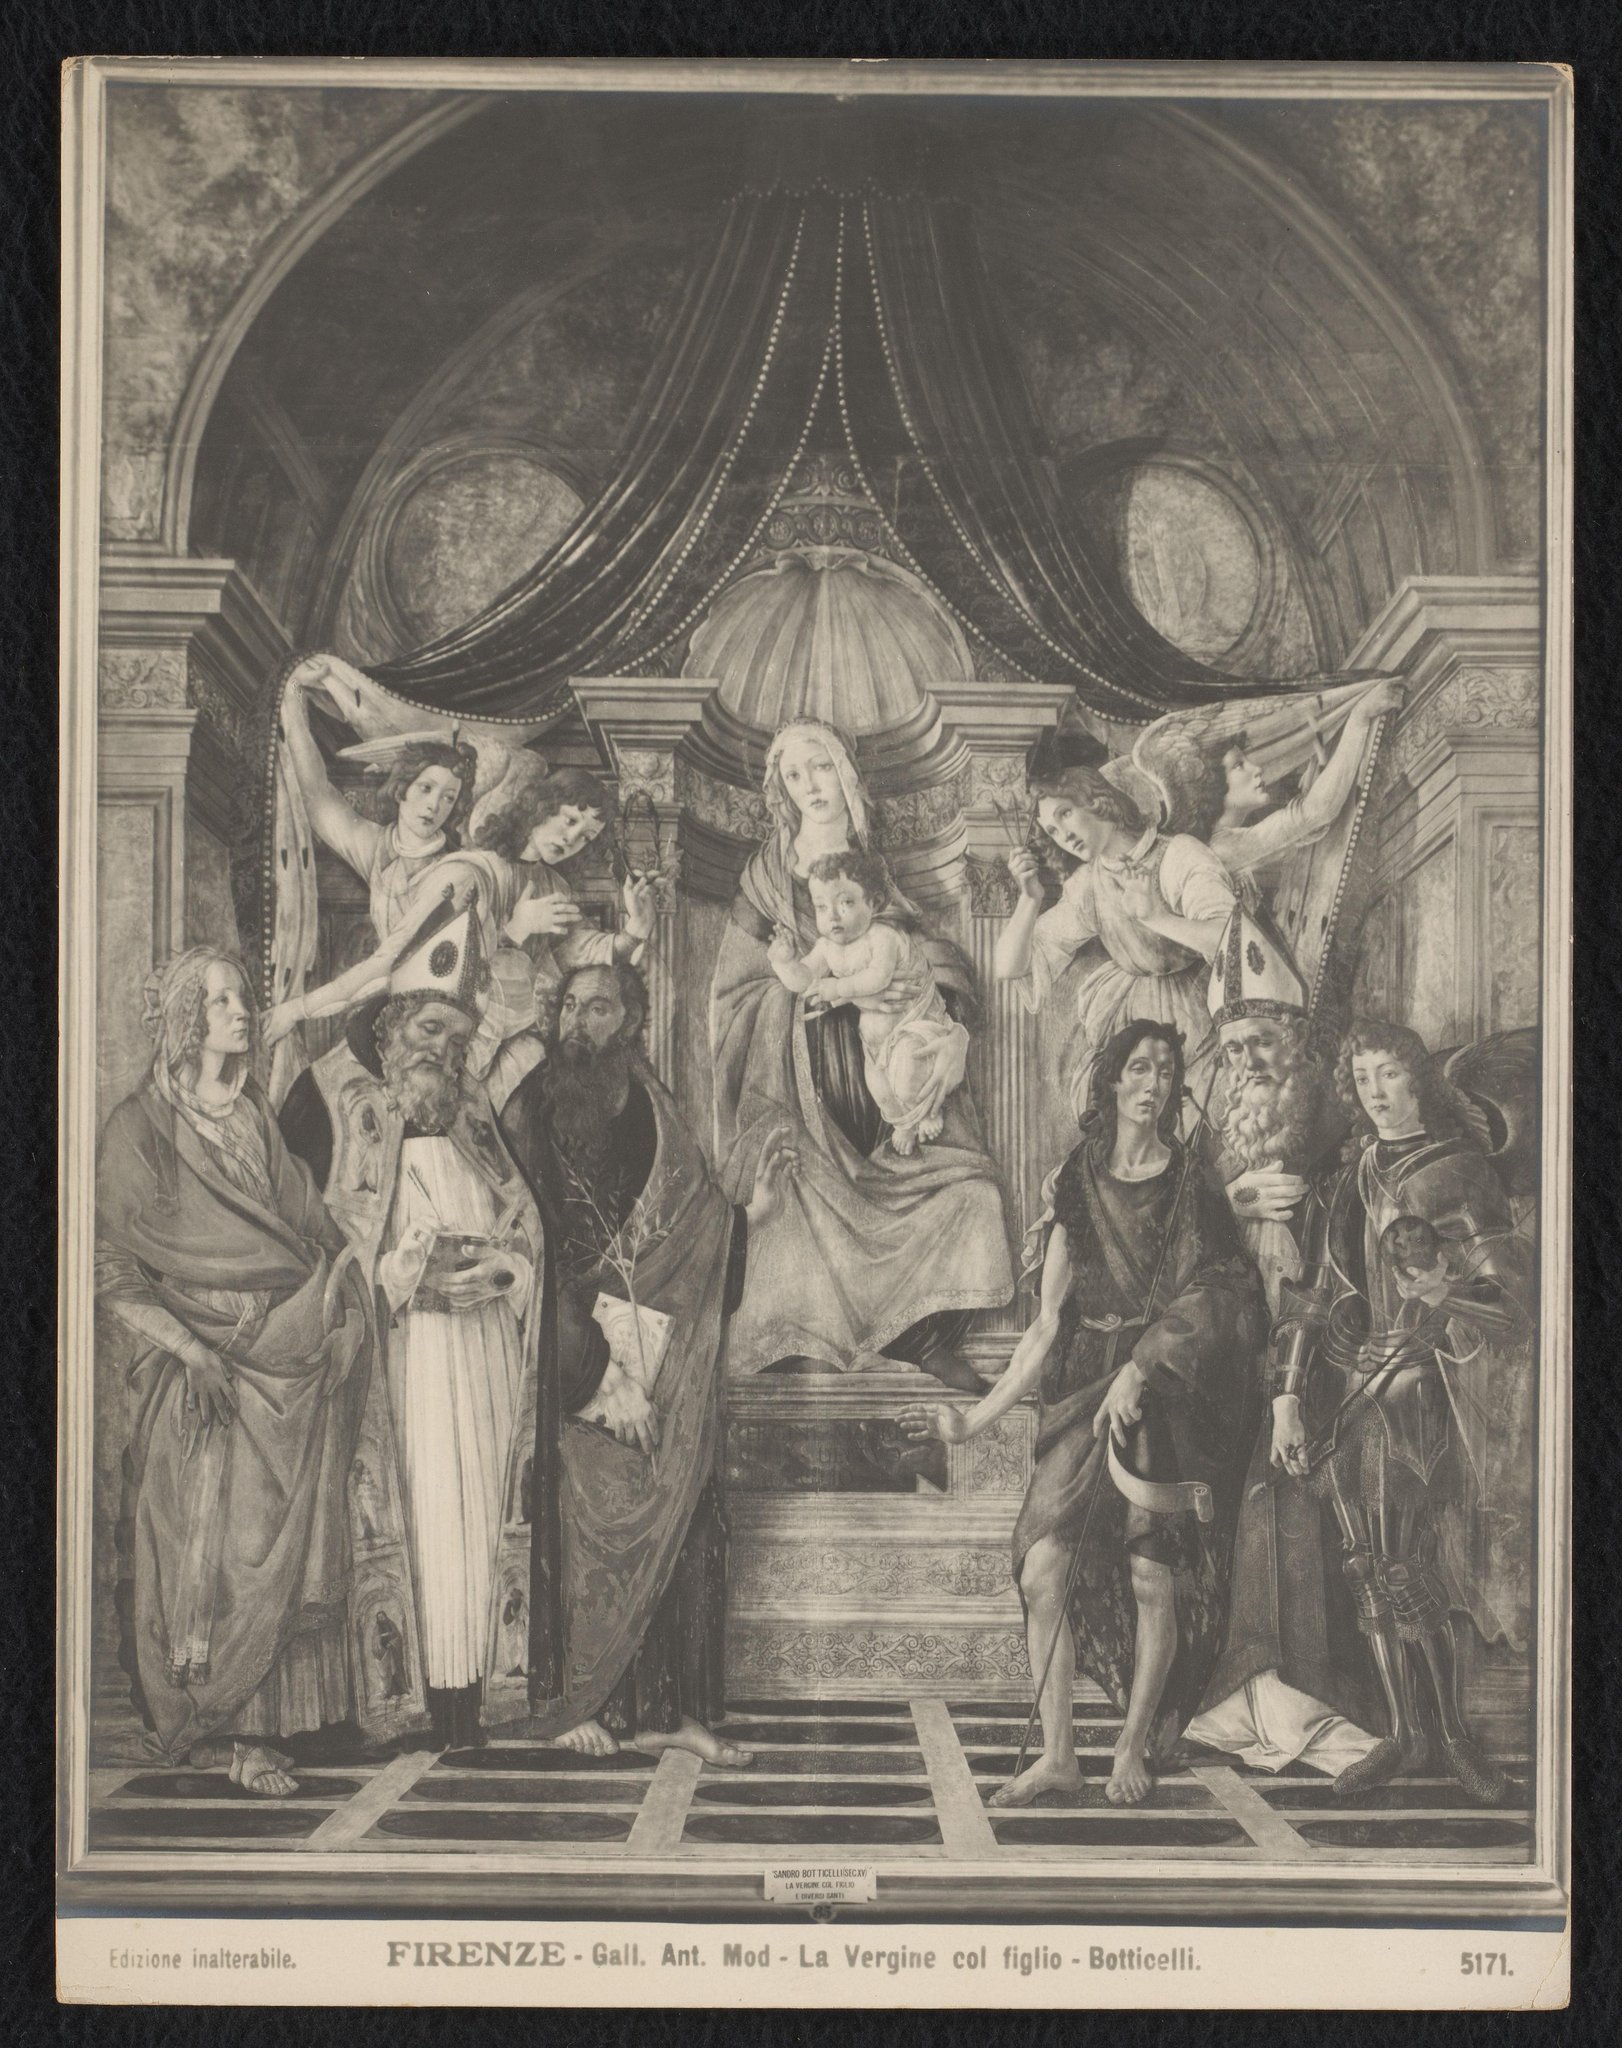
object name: reproduction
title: Firenze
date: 1901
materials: paper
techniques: gelatin silver print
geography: florence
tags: picture, painting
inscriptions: collector's mark: ‘RIJKS SCHOOL VOOR KUNSTNIJVERHEID/ GROEP’, number: ‘5171.’, inscription: ‘Edizione inalterabile.’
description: Deze foto maakt deel uit van een omslag.